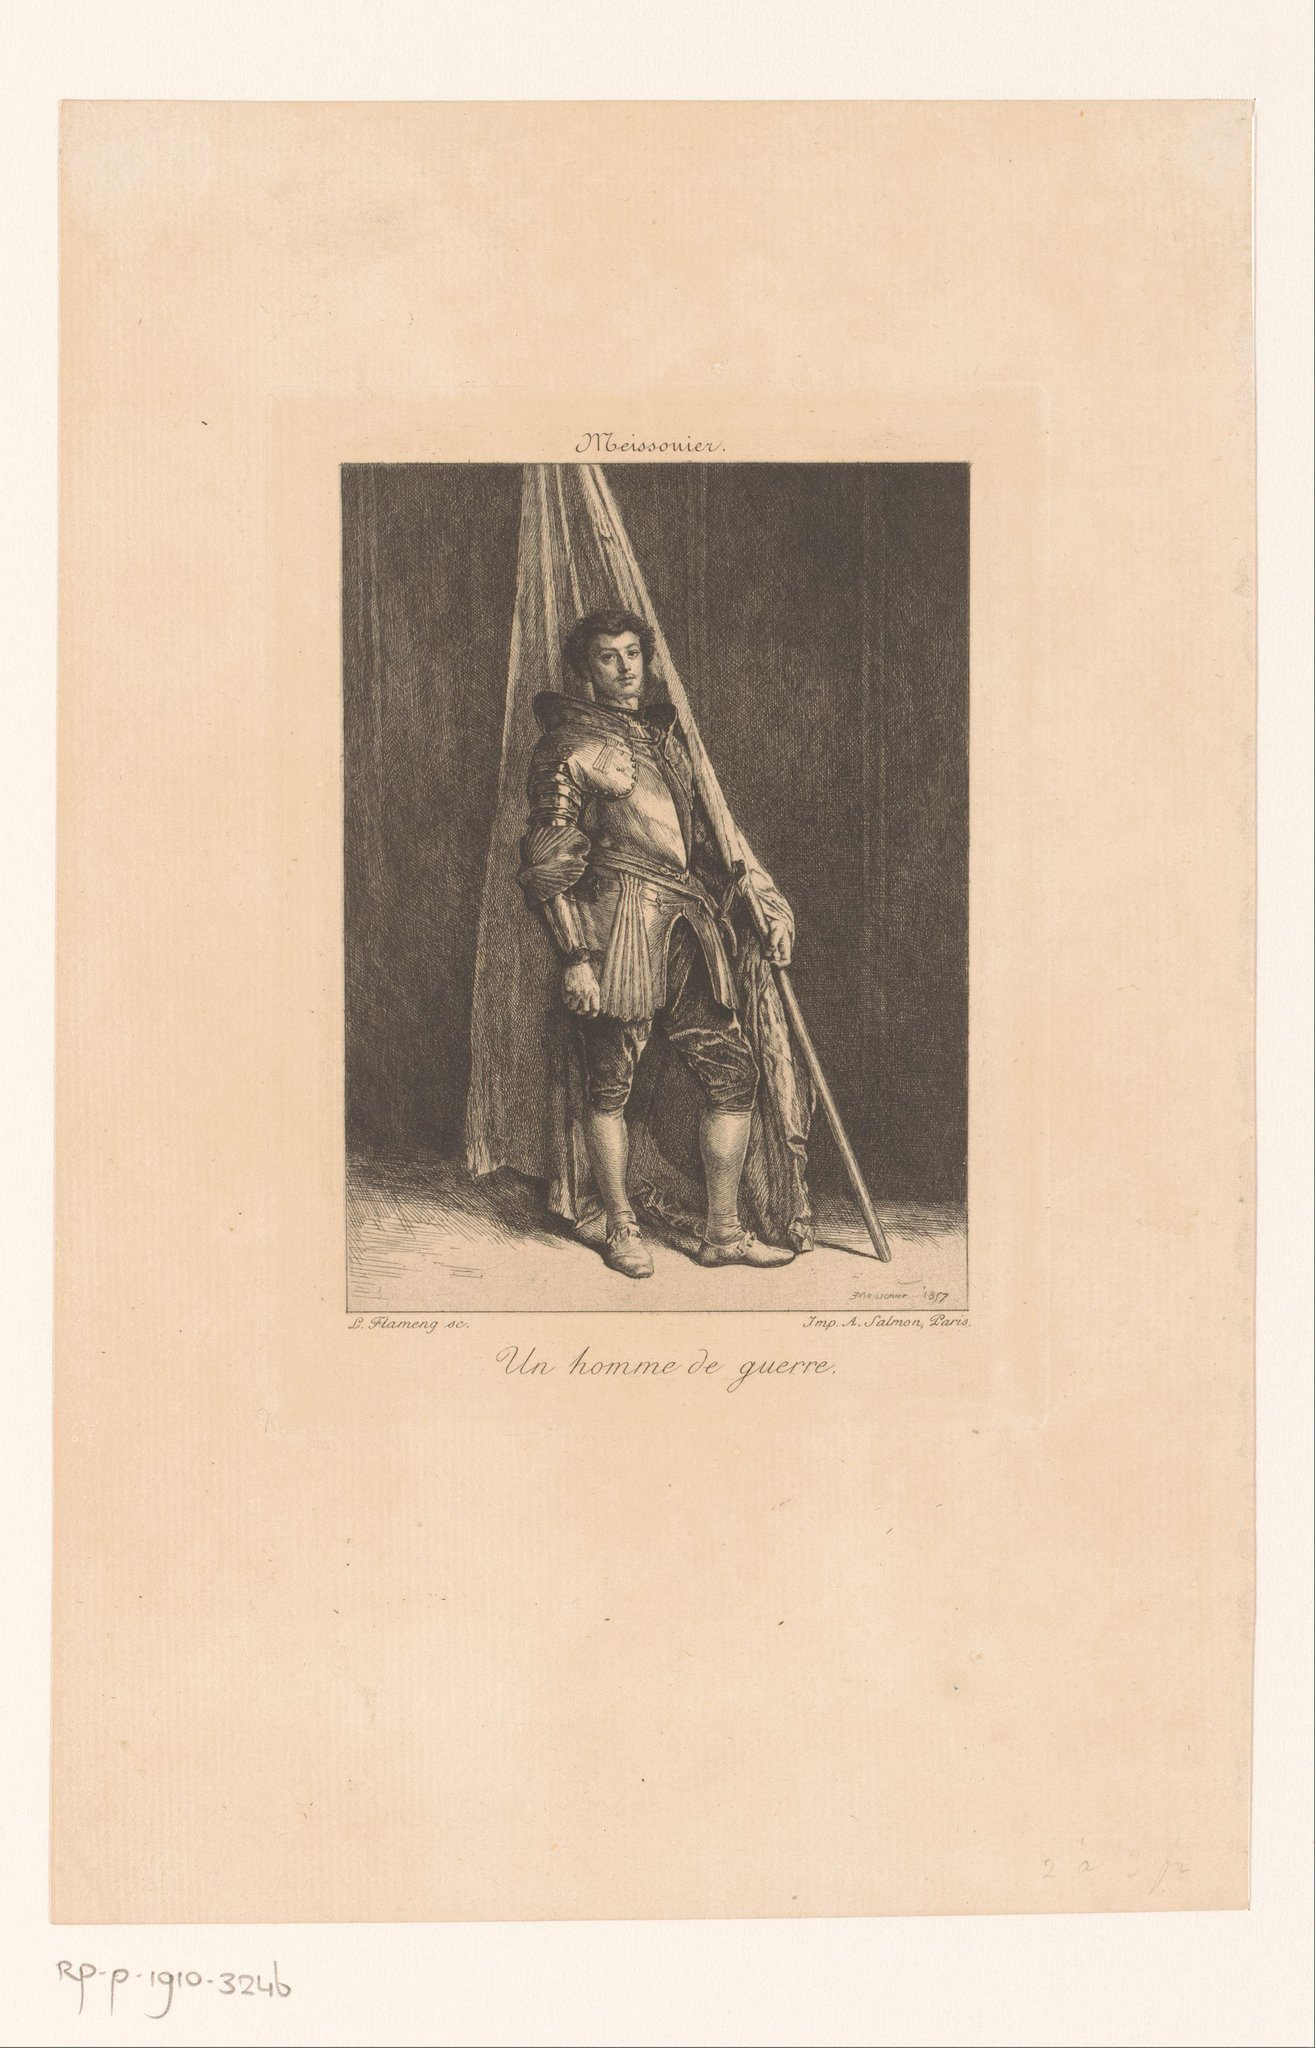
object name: print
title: Soldaat met een regimentsvlag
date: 1857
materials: paper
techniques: etching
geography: paris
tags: private soldier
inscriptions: collector's mark: Lugt 2228